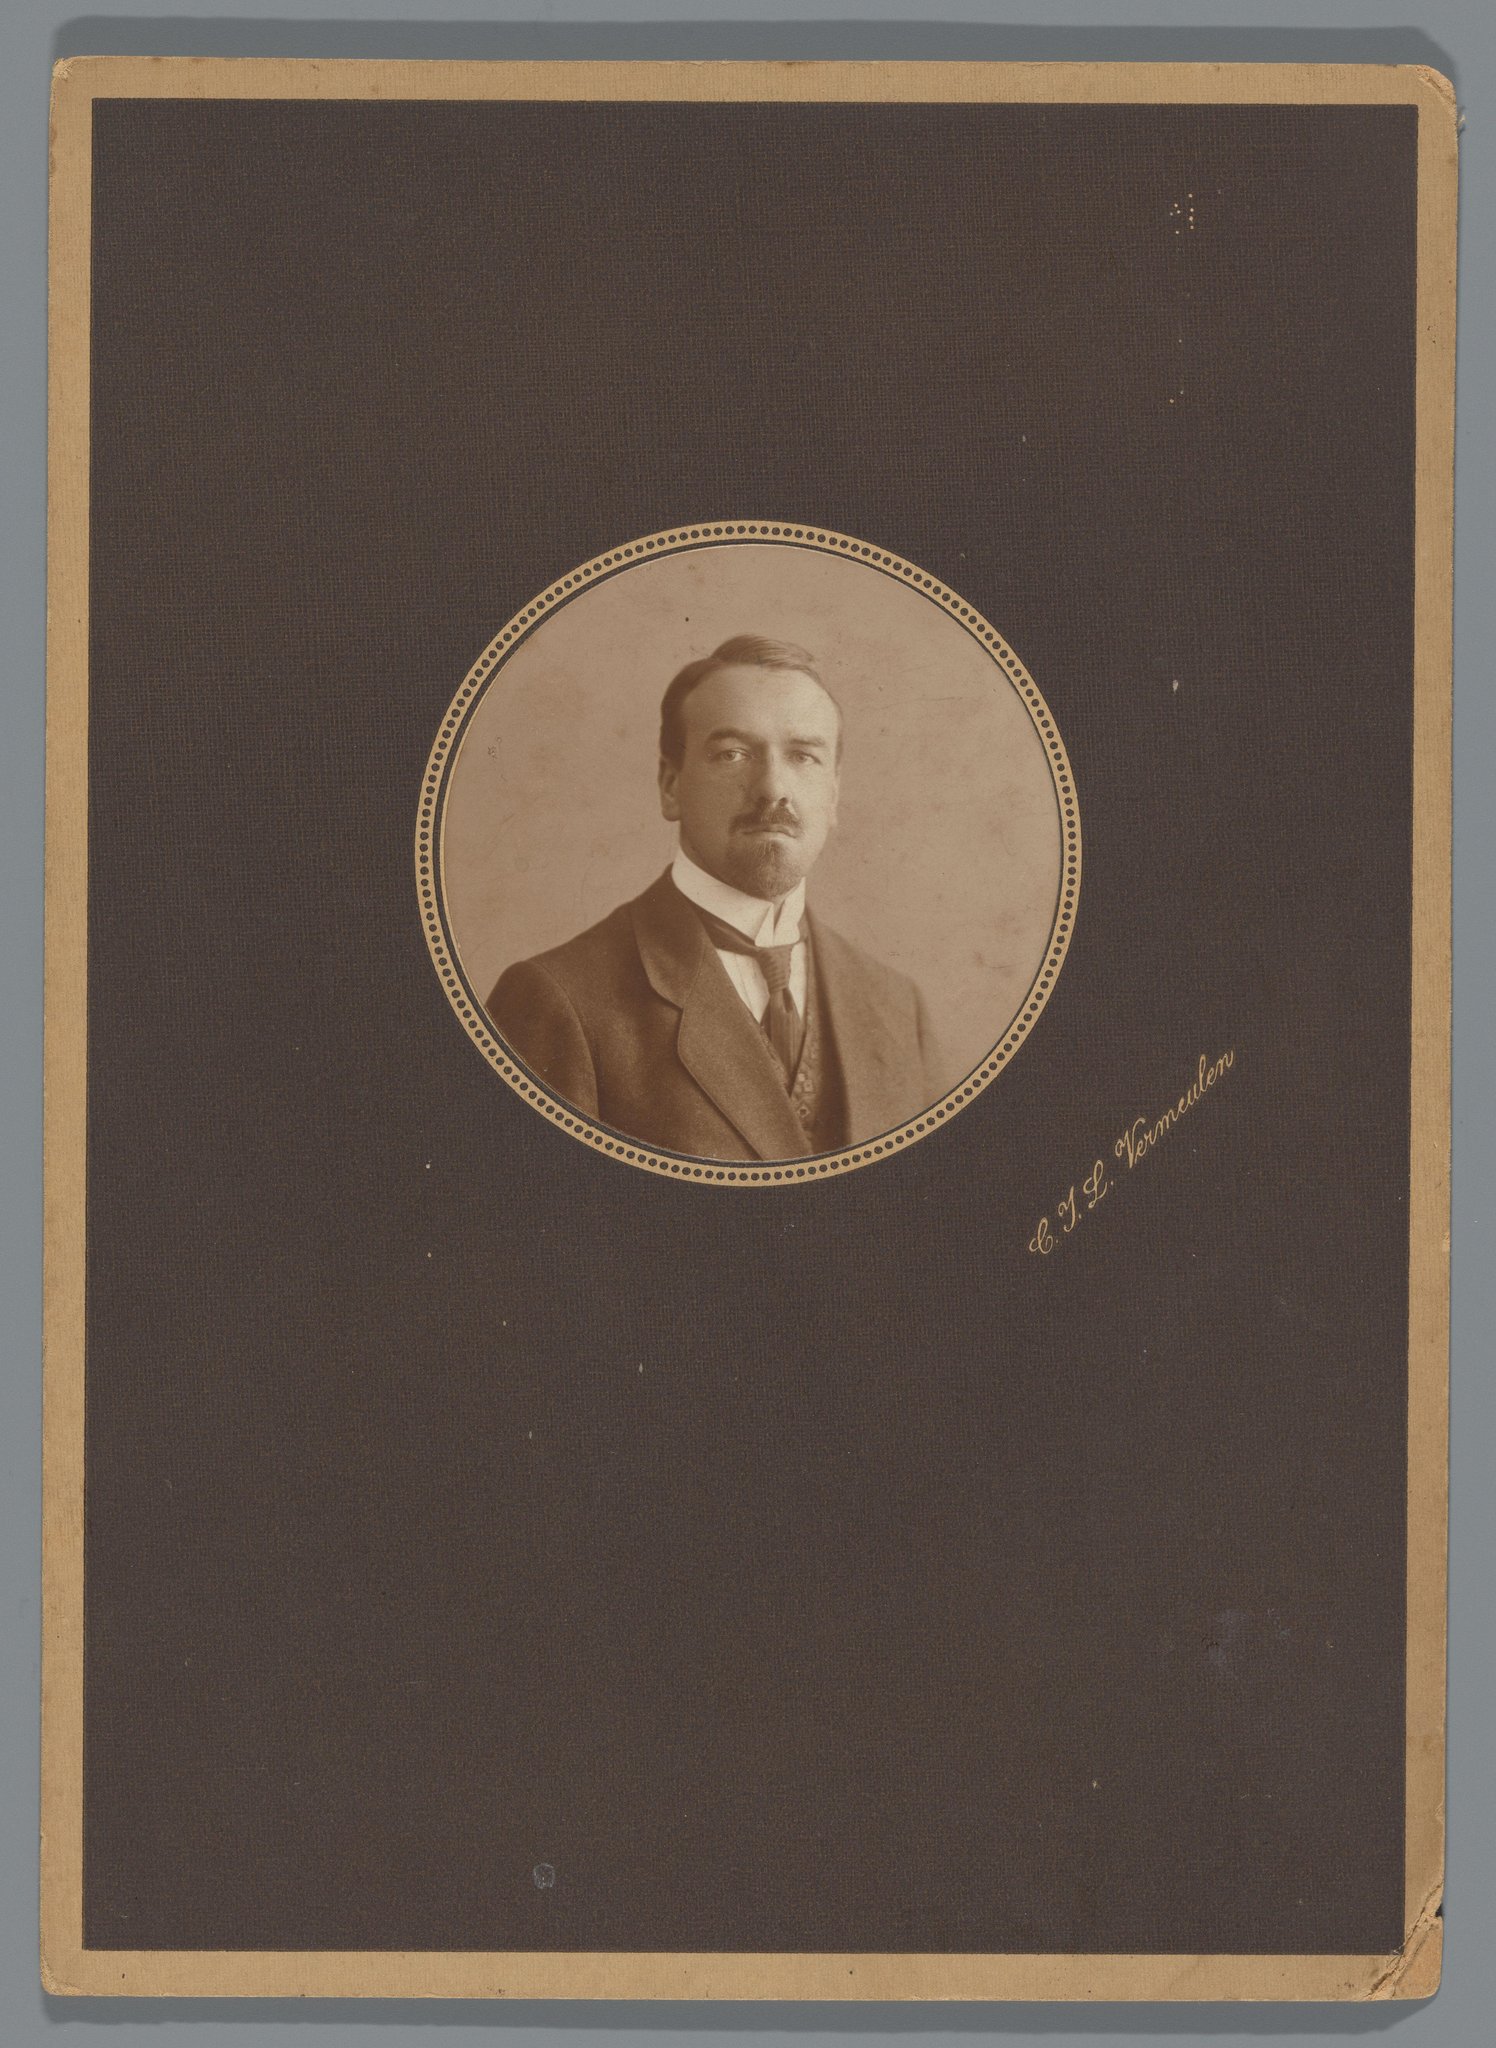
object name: photograph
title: Portret van een onbekende man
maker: cornelis johannes lodewicus vermeulen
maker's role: fotograaf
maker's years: 1861-1936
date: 1900-1920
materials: paper, cardboard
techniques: gelatin silver print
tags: adult man, historical persons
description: De geportretteerde man is ook afgebeeld op RP-F-F20494.